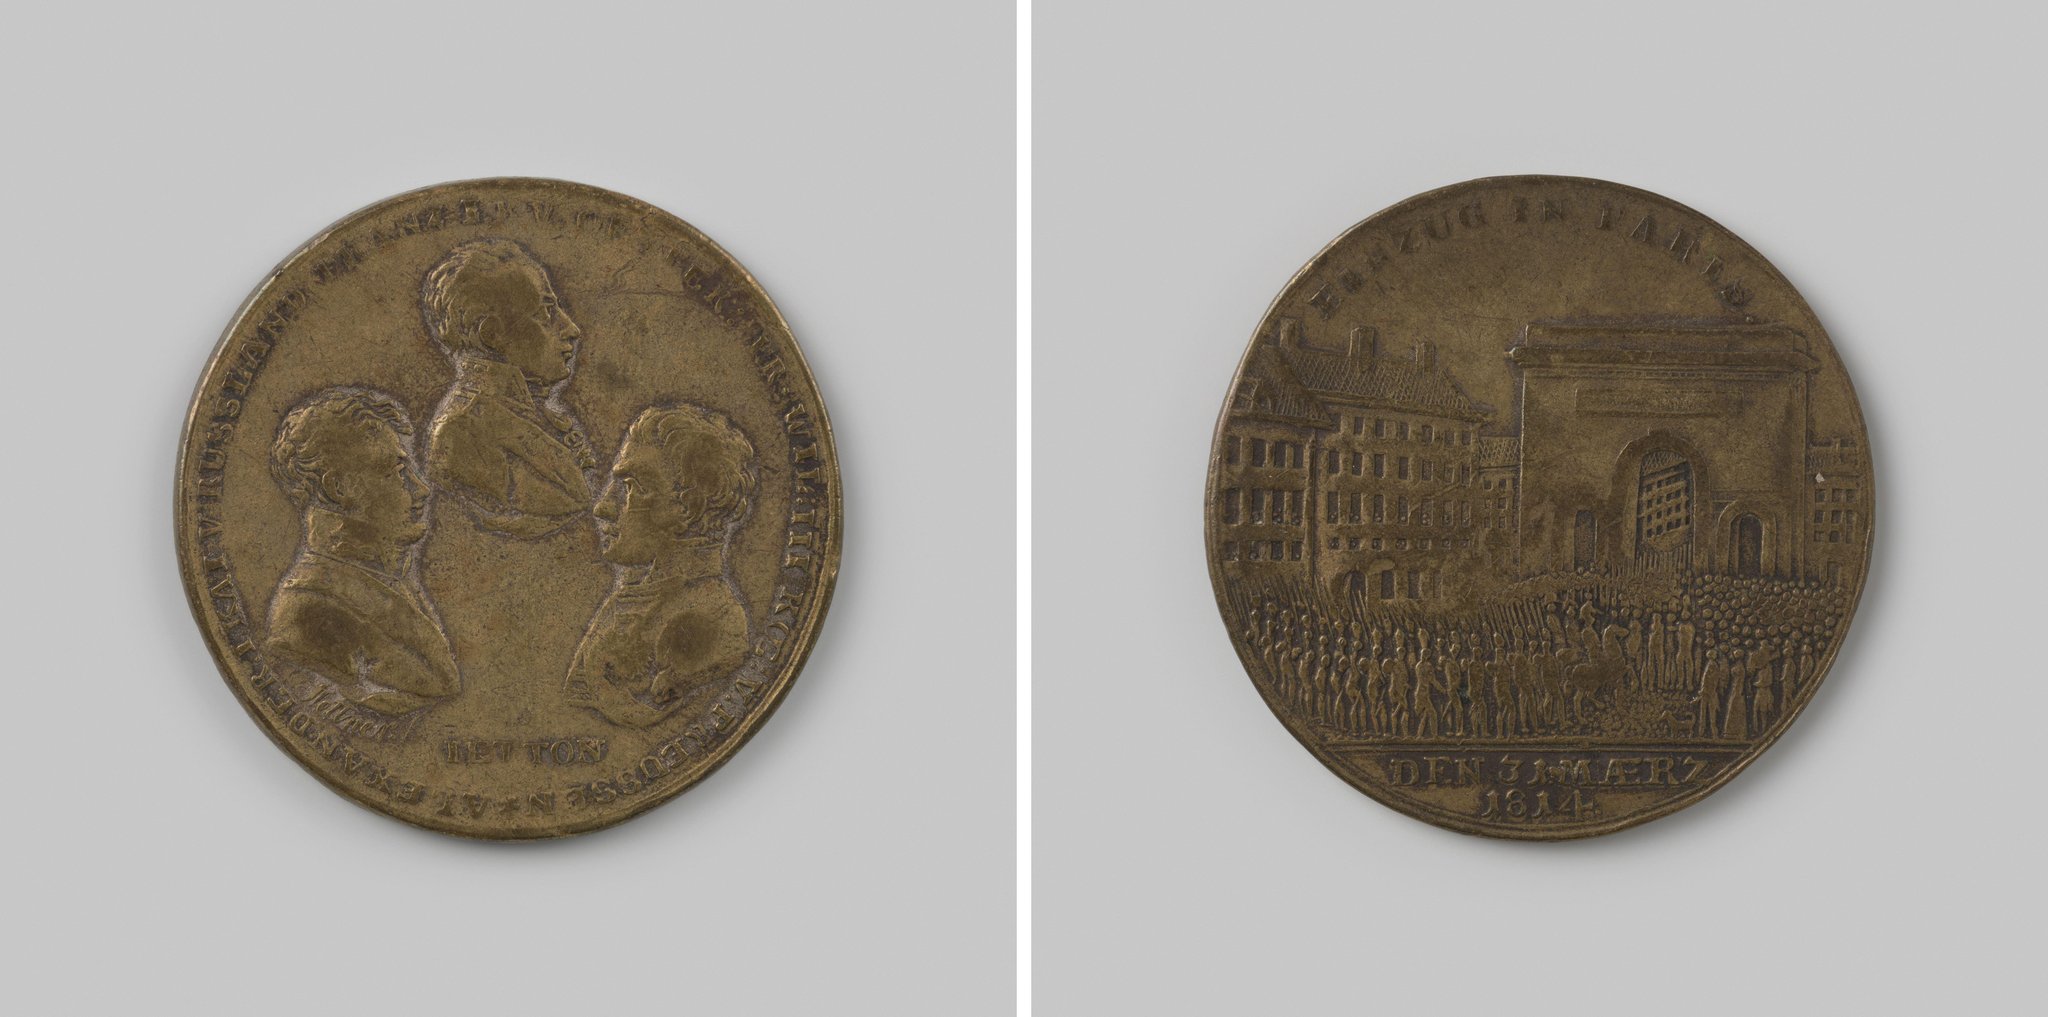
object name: history medal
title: Intocht van de troepen der geallieerden in Parijs 1814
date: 1814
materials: brass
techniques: striking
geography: nuremberg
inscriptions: inscription: ‘DEN 3 MÆRZ / 1814’, circumscription, circumscription: ‘EINZUG IN PARIS’, signature: ‘Stettner f’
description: Verzilverd messing penning, op de voorzijde de portretten van Alexander van Rusland, Frans II van Oostenrijk en Frederik Willem III van Pruissen, met omschrift en afsnedetekst, op de keerzijde soldaten marcherend door een triomfpoort, met omschrift en afsnedetekst.